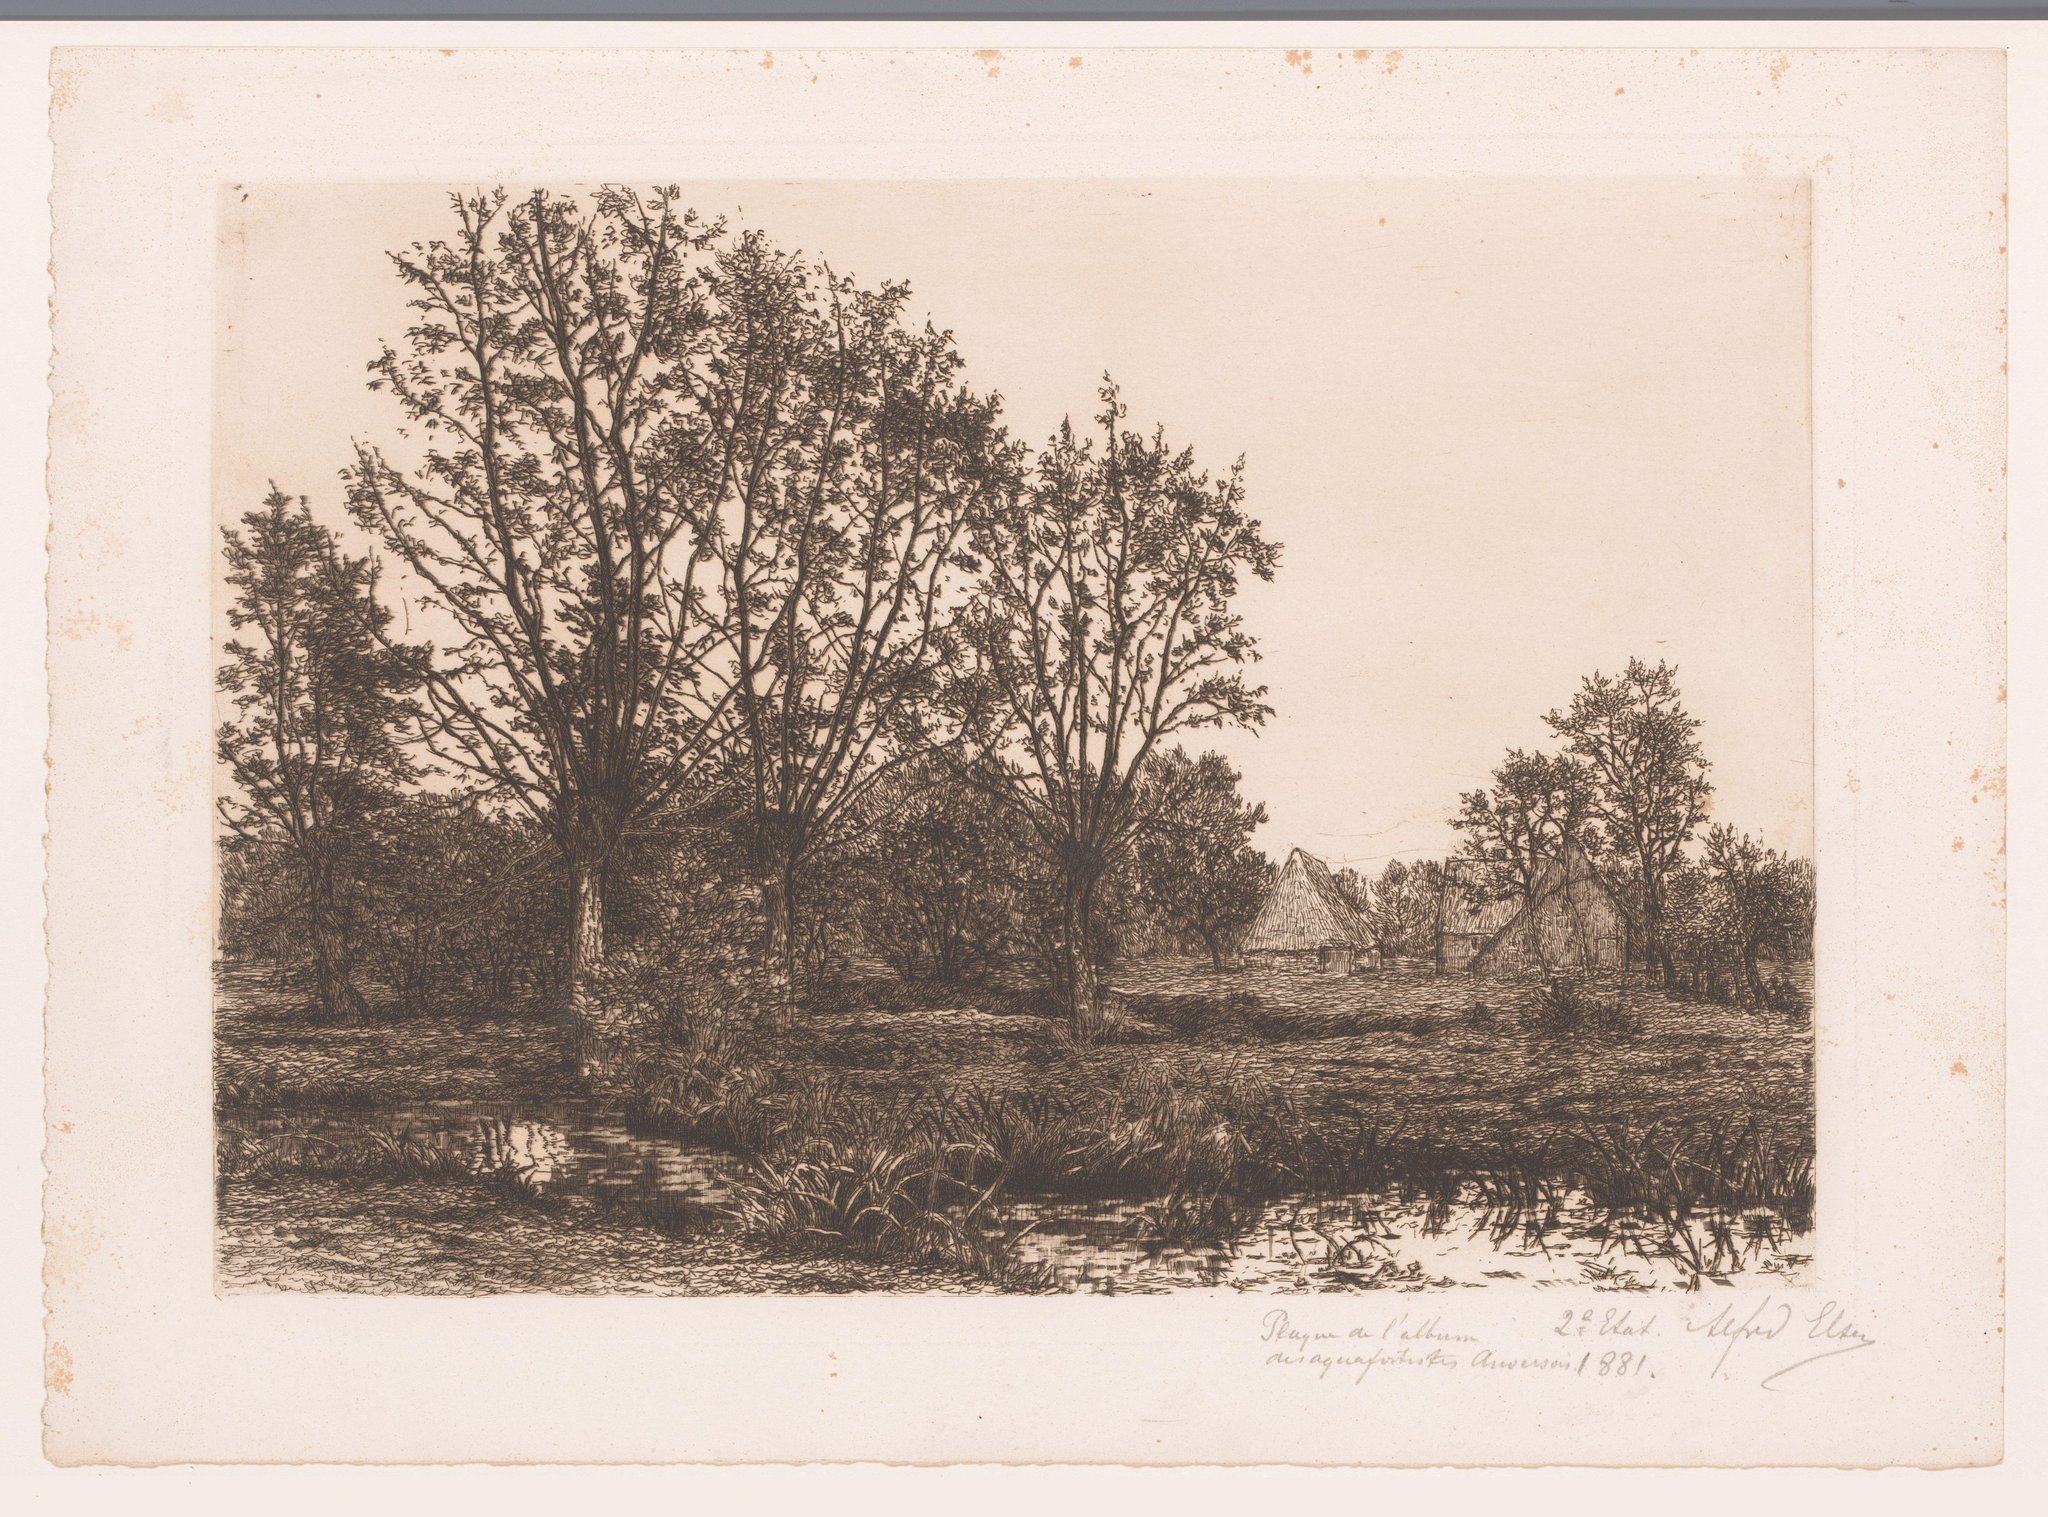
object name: print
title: Landschap met vier wilgen en een beek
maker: alfred elsen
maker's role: painter, print maker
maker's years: 1850-1914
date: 1881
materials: paper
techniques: etching, intaglio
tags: brook, trees: willow, farm or solitary house in landscape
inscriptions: inscription: ‘Plaque au l'album des aquafortistes Anversois; 2e Etat’, collector's mark: Lugt 2228